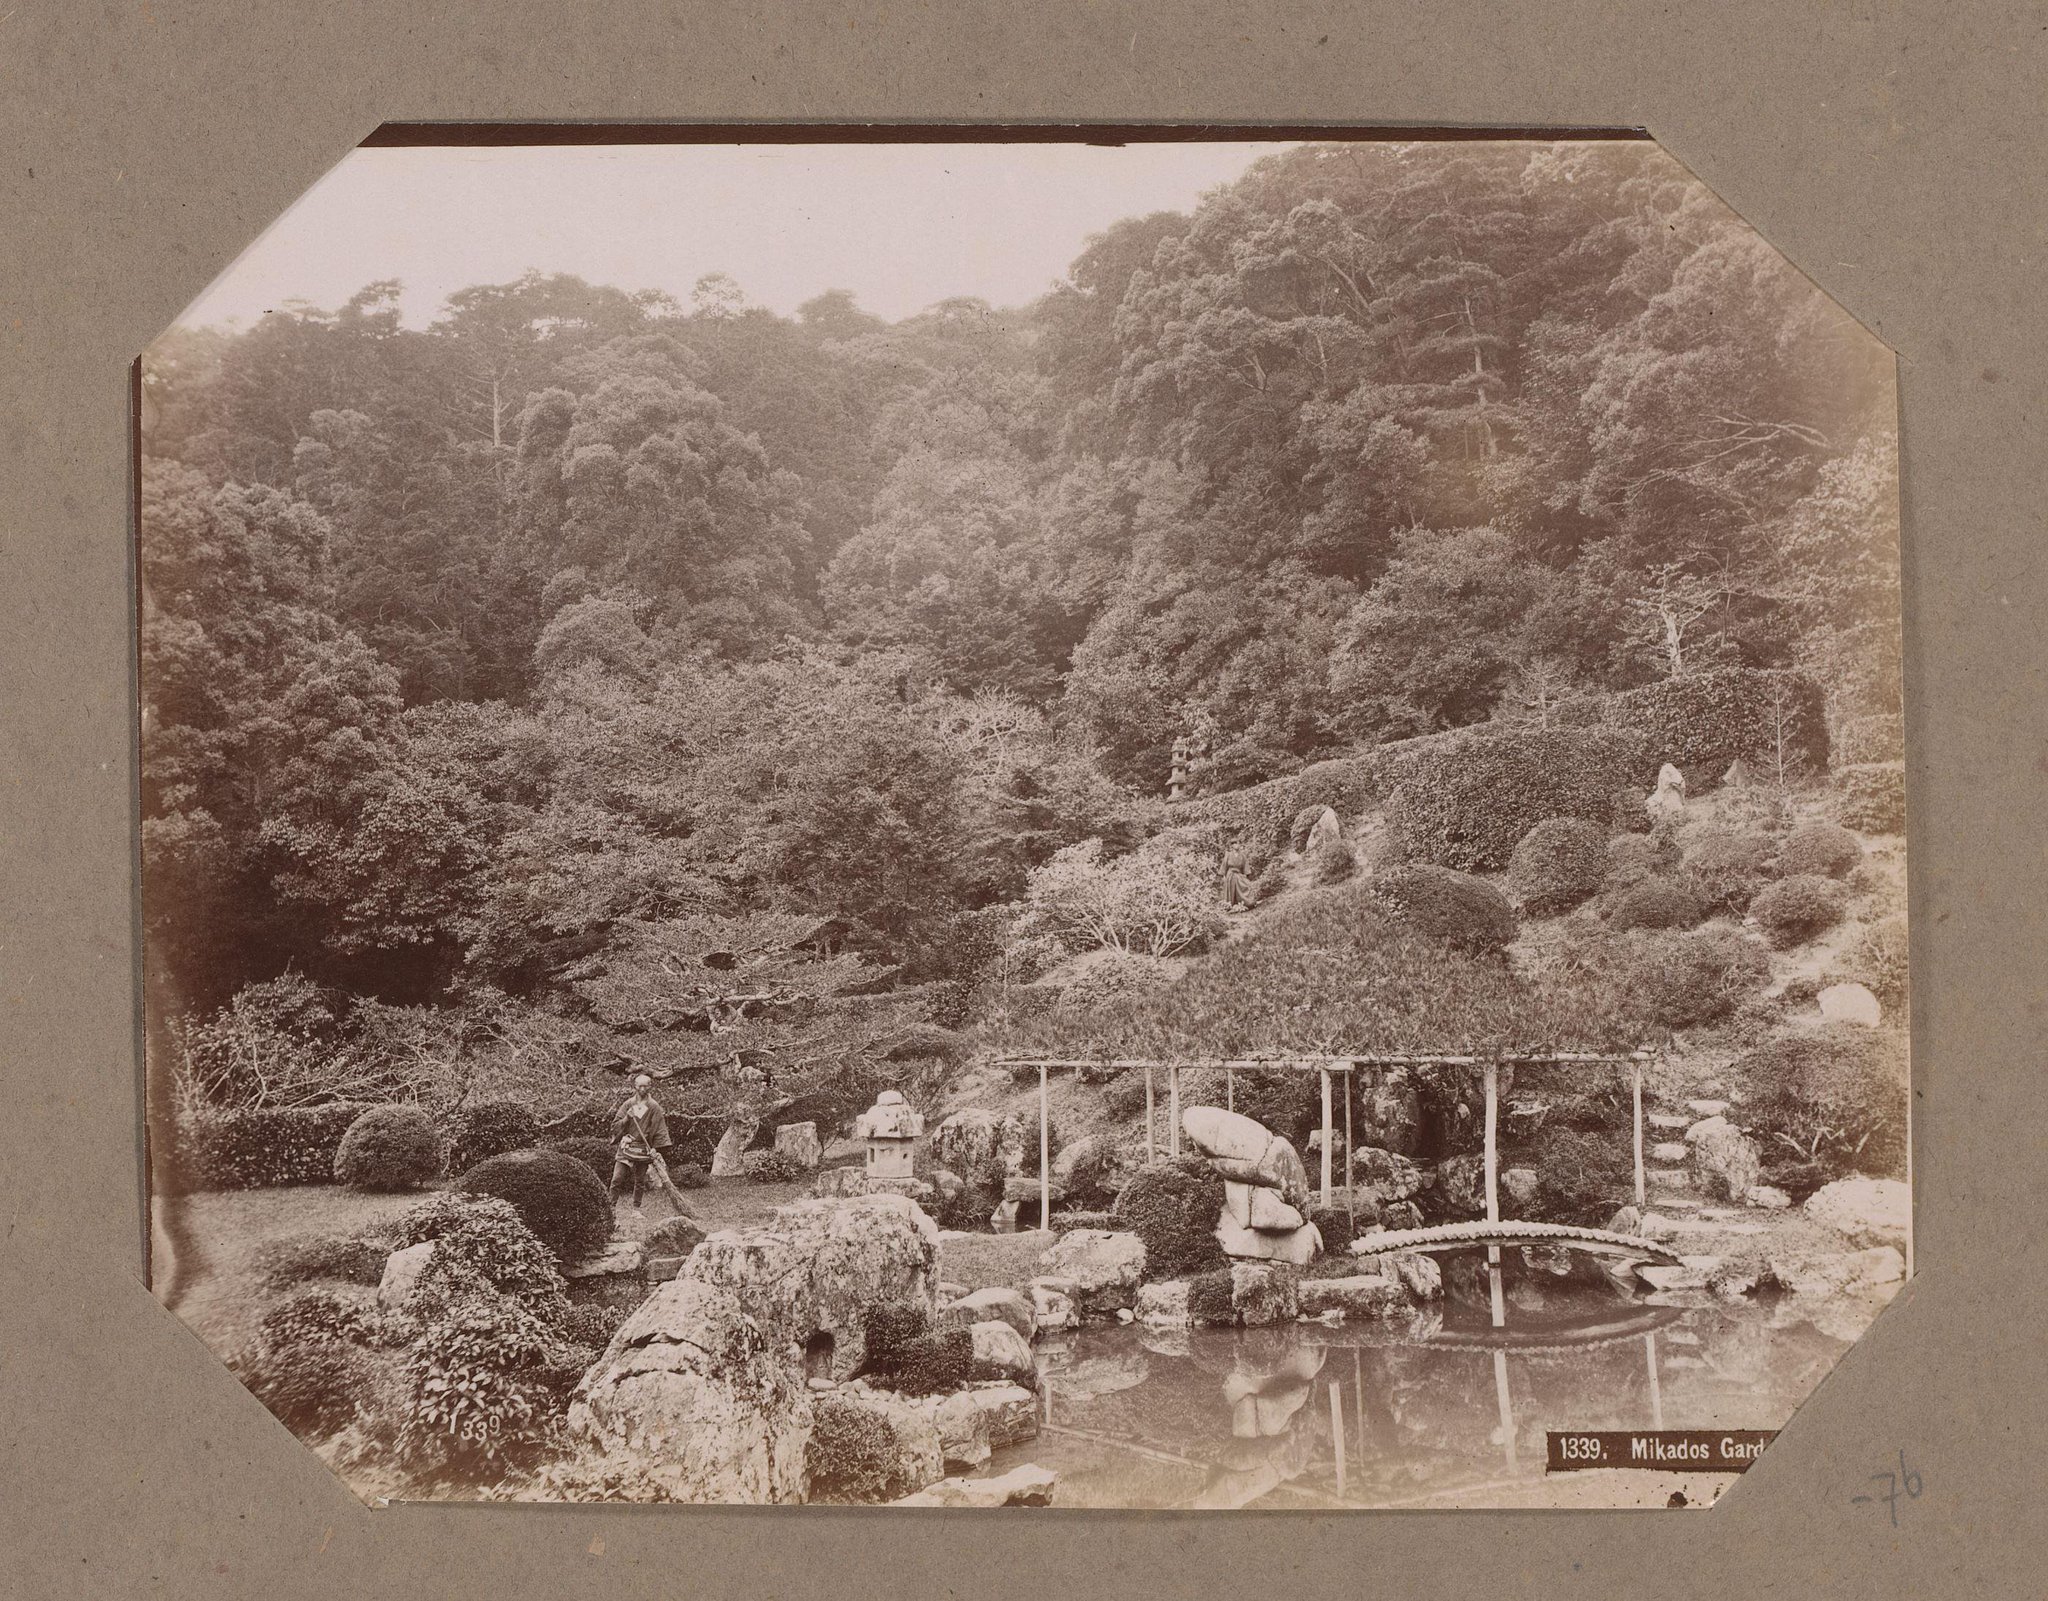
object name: photograph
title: Tuin van het Keizerlijk Paleis in Kyoto, Japan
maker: kusakabe kimbei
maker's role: fotograaf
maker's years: 1841-1934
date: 1890-1903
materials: paper, photographic support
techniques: albumen print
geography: kyoto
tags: trees, garden, palace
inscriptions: inscription: ‘1339 Mikados Garden Kioto’